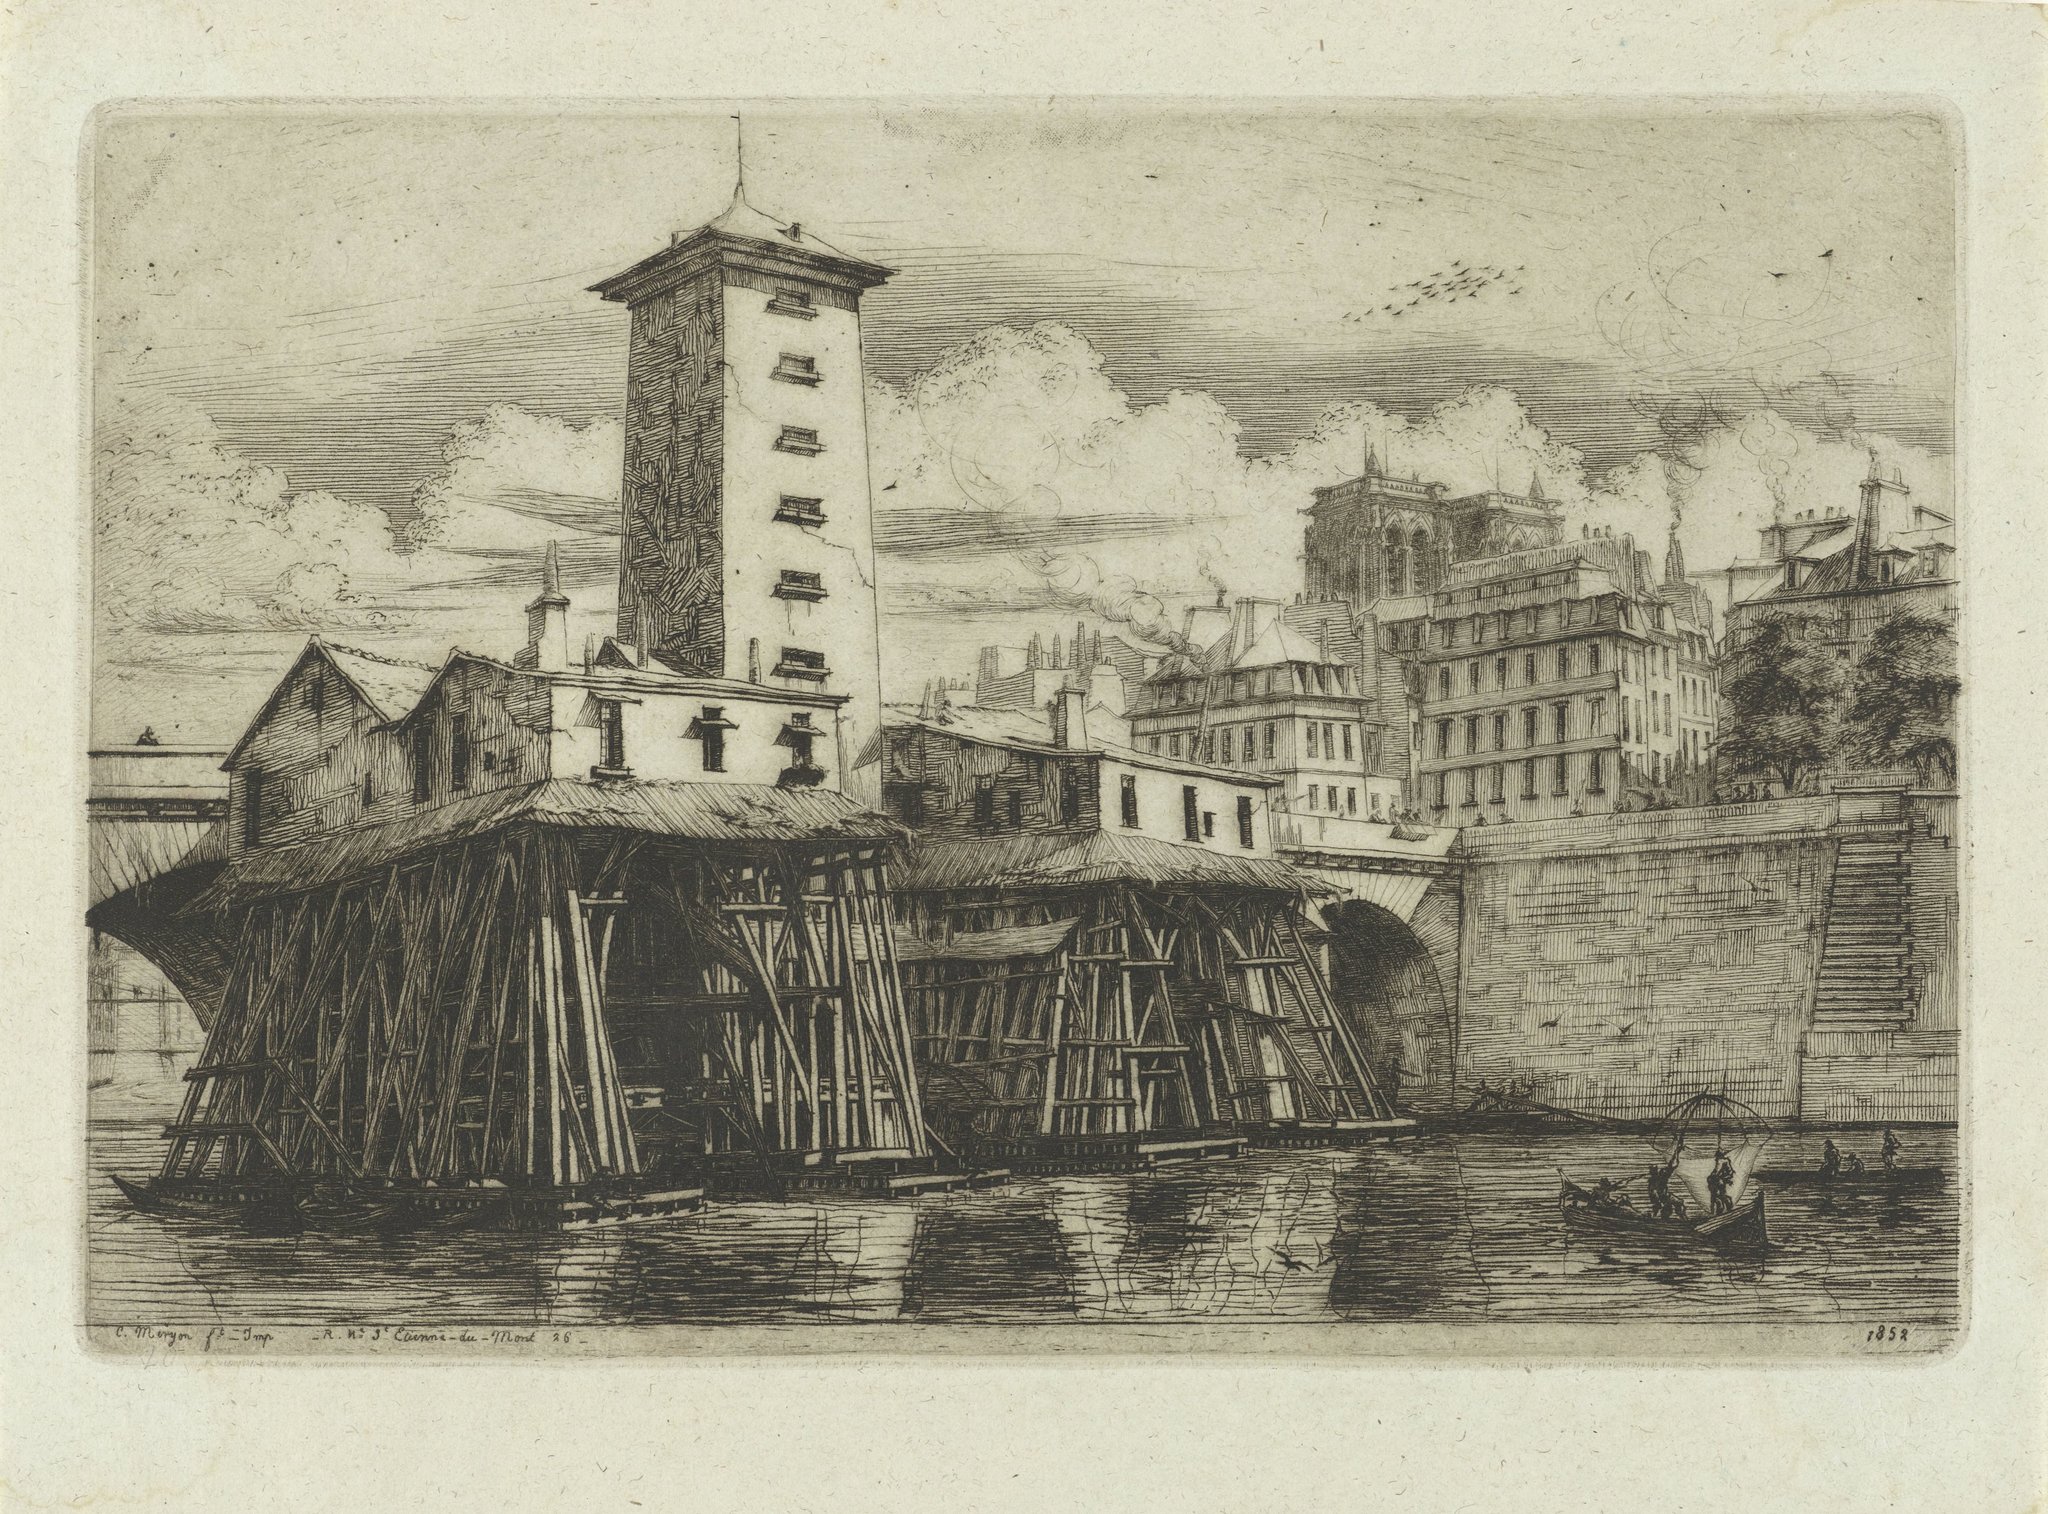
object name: print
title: La Pompe Notre-Dame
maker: charles meryon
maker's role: print maker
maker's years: 1821-1868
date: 1852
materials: paper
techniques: etching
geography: paris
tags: purification system (~ water supply), paris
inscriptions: collector's mark:, collector's mark: Lugt 2228, collector's mark: Lugt 1816d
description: Afkomstig uit album met titel Eaux-Fortes par Meryon. Het album bevatte een titelblad en twaalf prenten op opzetvellen welke bij elkaar waren gebracht door het Ministère de l'intérieur te Parijs op voorspraak van Jules Niels. Vanwege de kwetsbaarheid van de prenten zijn deze uit het album gehaald en wordt de oude band met lege opzetvellen in de collectie van het RMA bewaard. Deze ets bevond zich op opzetvel p. 9. Meryon was van plan om een serie stadsgezichten van Parijs in een album uit te geven. De serie losse prenten staat bekend onder de titel Eaux-Fortes sur Paris. Waarschijnlijk heeft Meryon in enkele gevallen op verzoek series gedrukt zoals voor het Parijse ministerie (De Groot 1991, p. 23, 24).